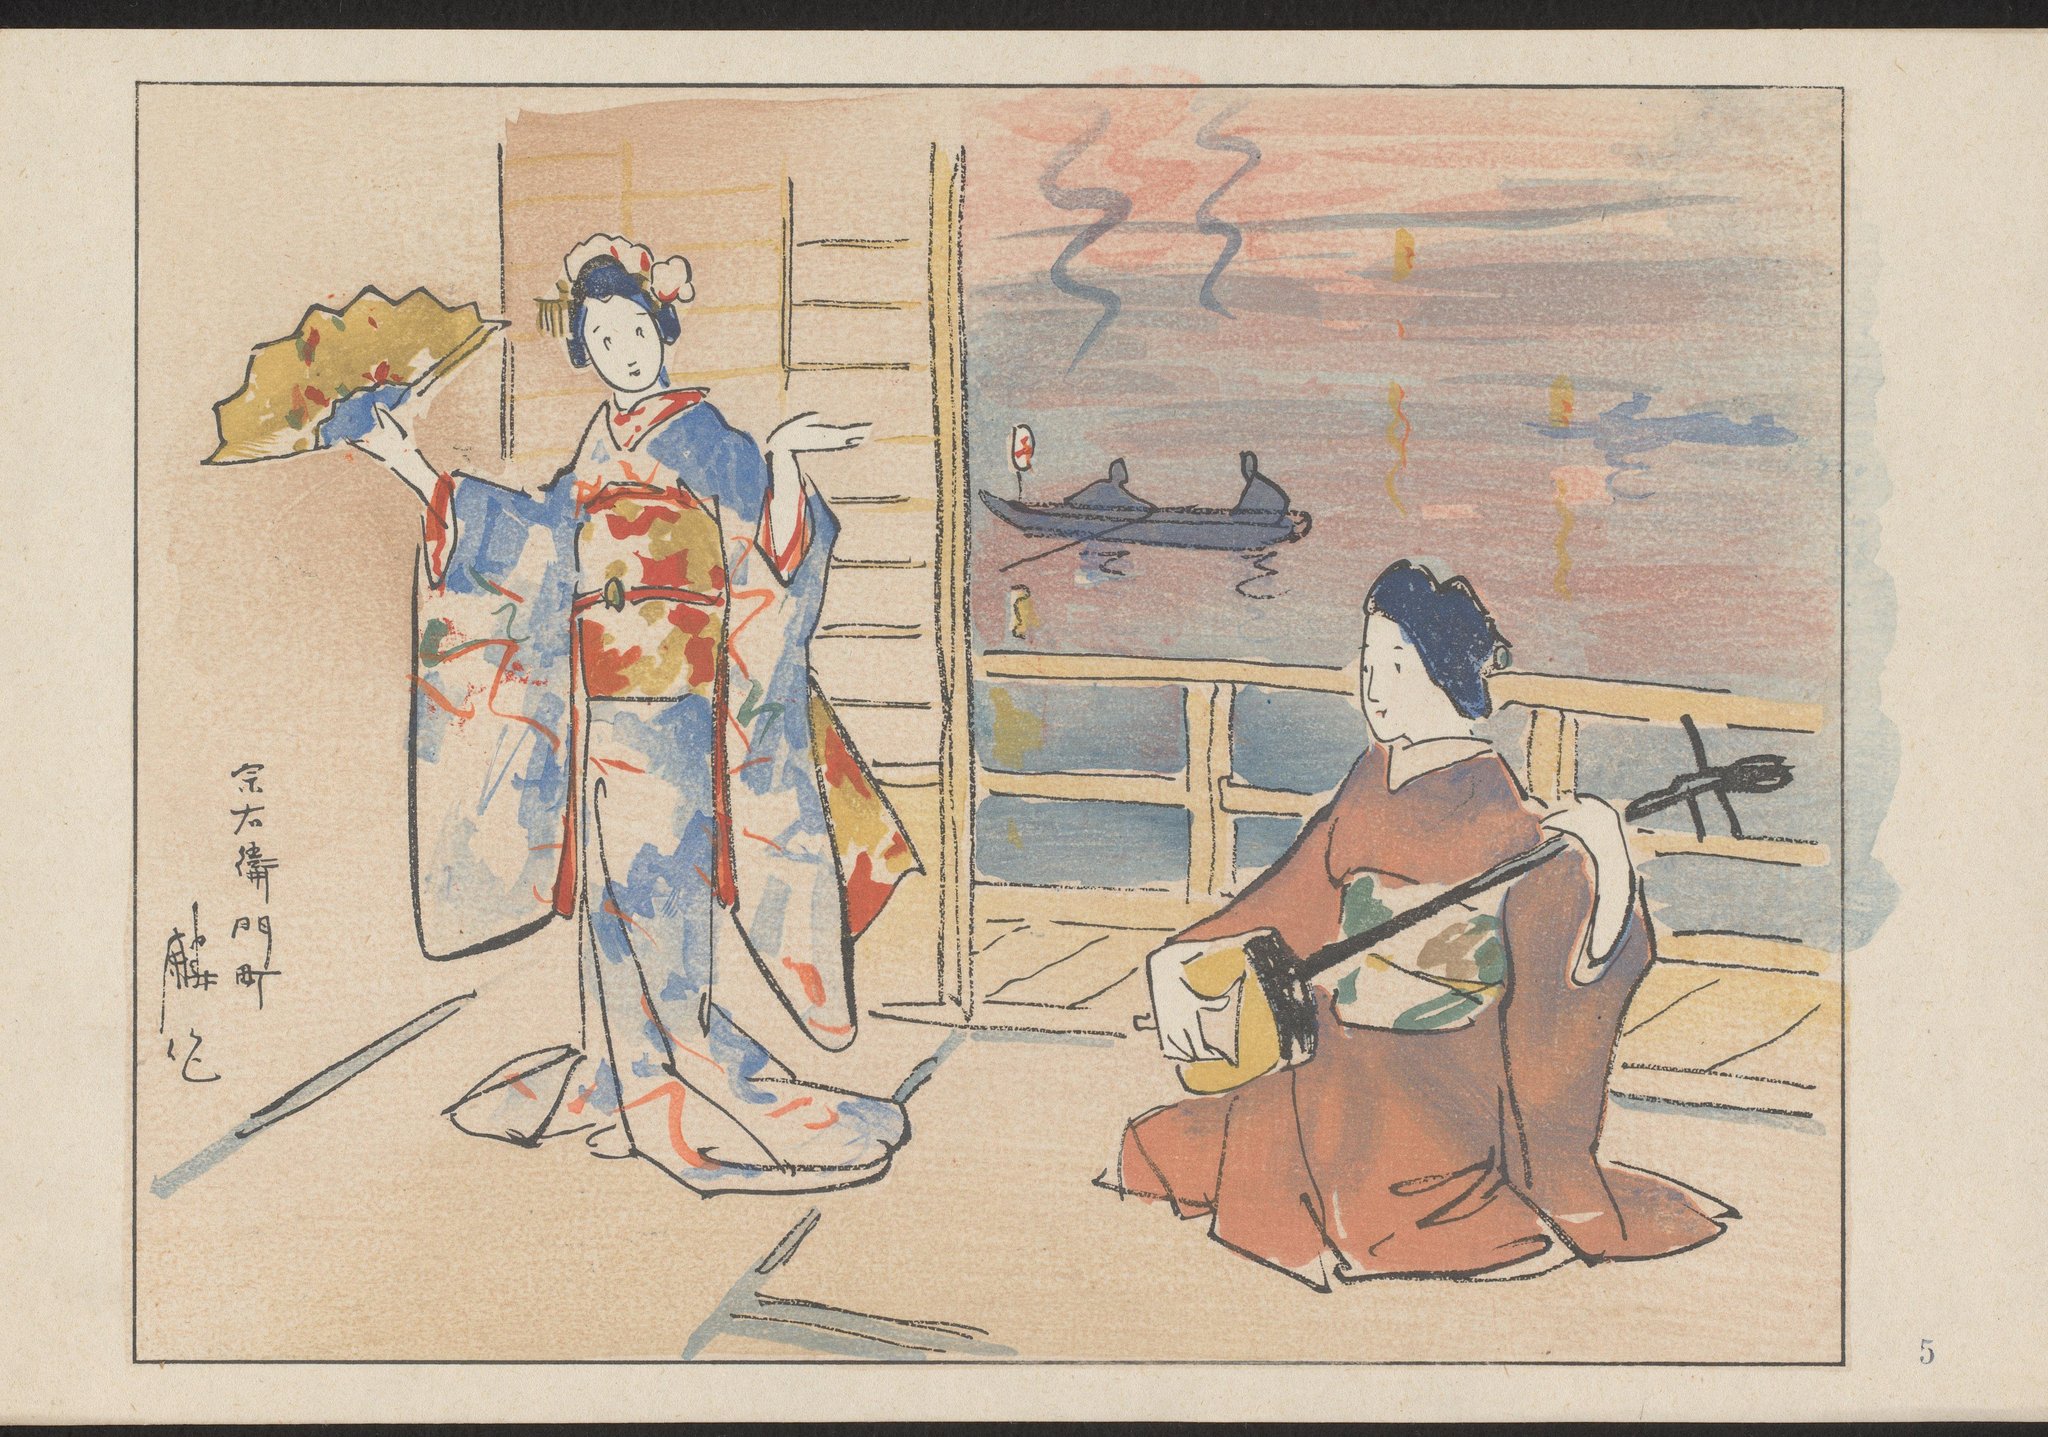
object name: print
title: Soemoncho, the gay quarter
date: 1947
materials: paper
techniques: woodcut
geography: japan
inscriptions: date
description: Een maiko danst met een waaier in de hand en een vrouw bespeelt een Japanse luit (shamisen), op de achtergrond het Dôtonbori kanaal.